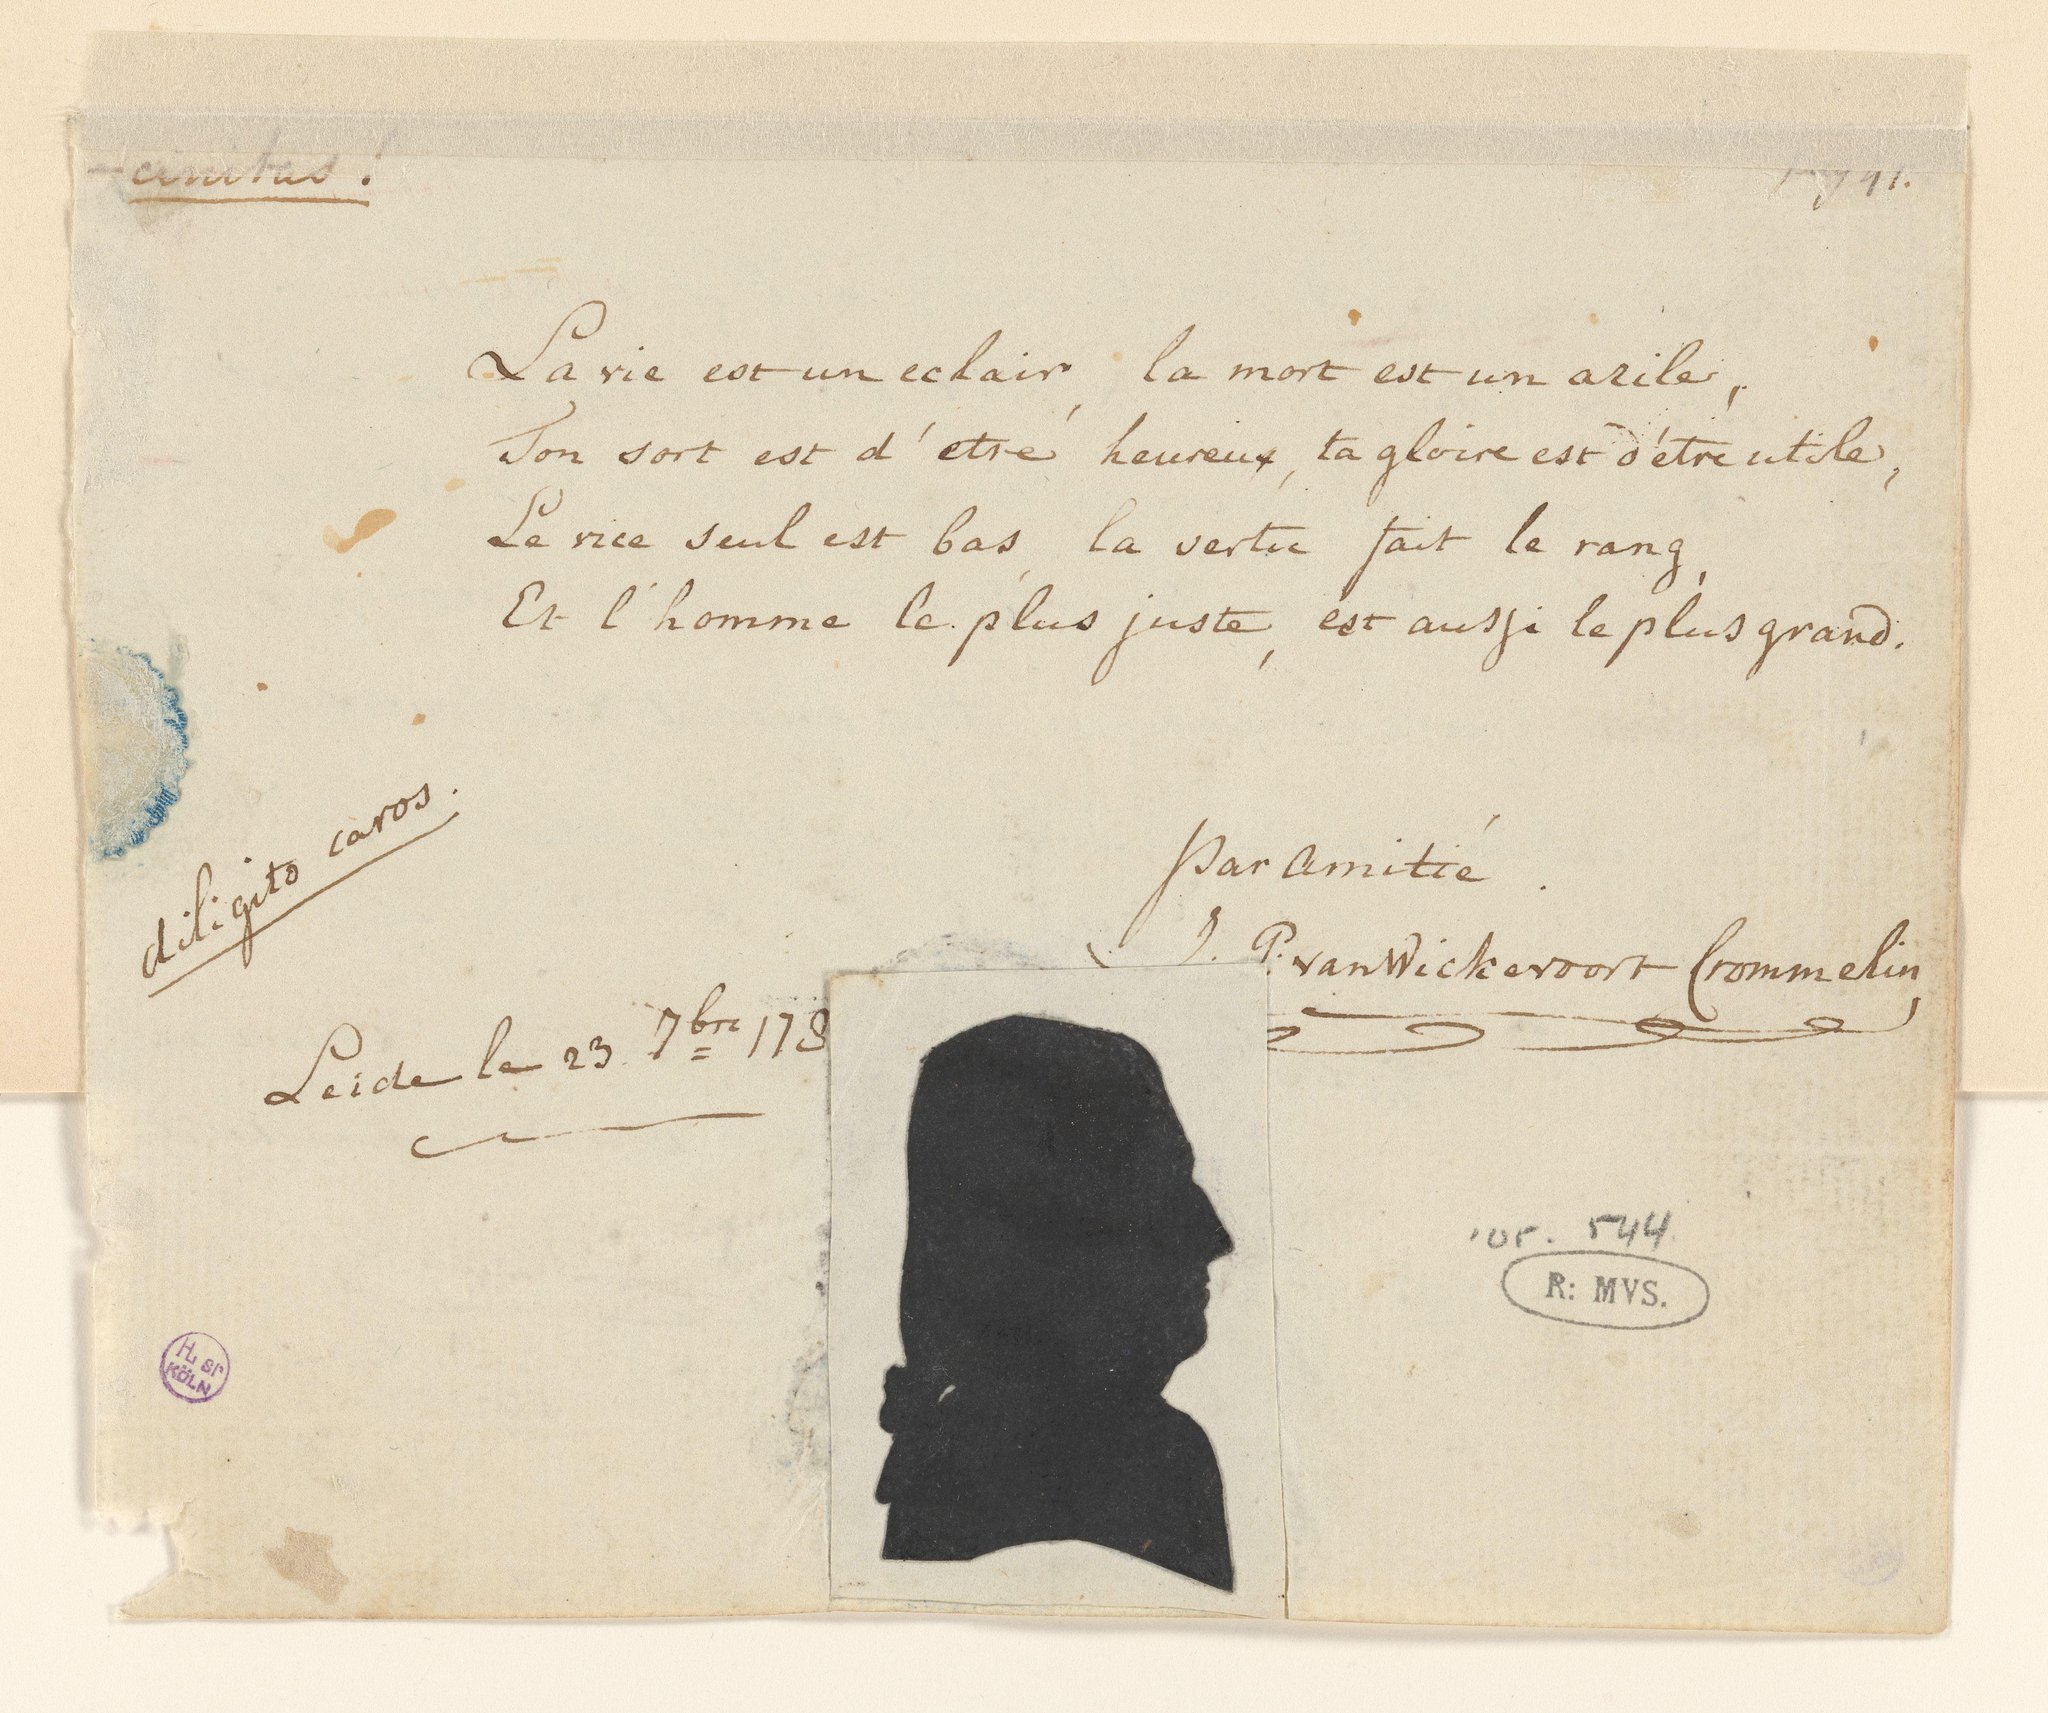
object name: silhouette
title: Silhouetportret van Jan Pieter van Wickevoort Crommelin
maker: Anonymous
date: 1783-1799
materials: paint, paper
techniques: brush, snipping, writing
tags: haarlem, politician, historical persons, politician, e.g. party leader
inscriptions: collector's mark: Lugt 2228, inscription: ‘cinitas! pag 41. ... van Wickevoort Crommelin’, collector's mark: Lugt 1337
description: Bladzijde uit het album amicorum van Johannes Beeldsnijder (1761-1817).